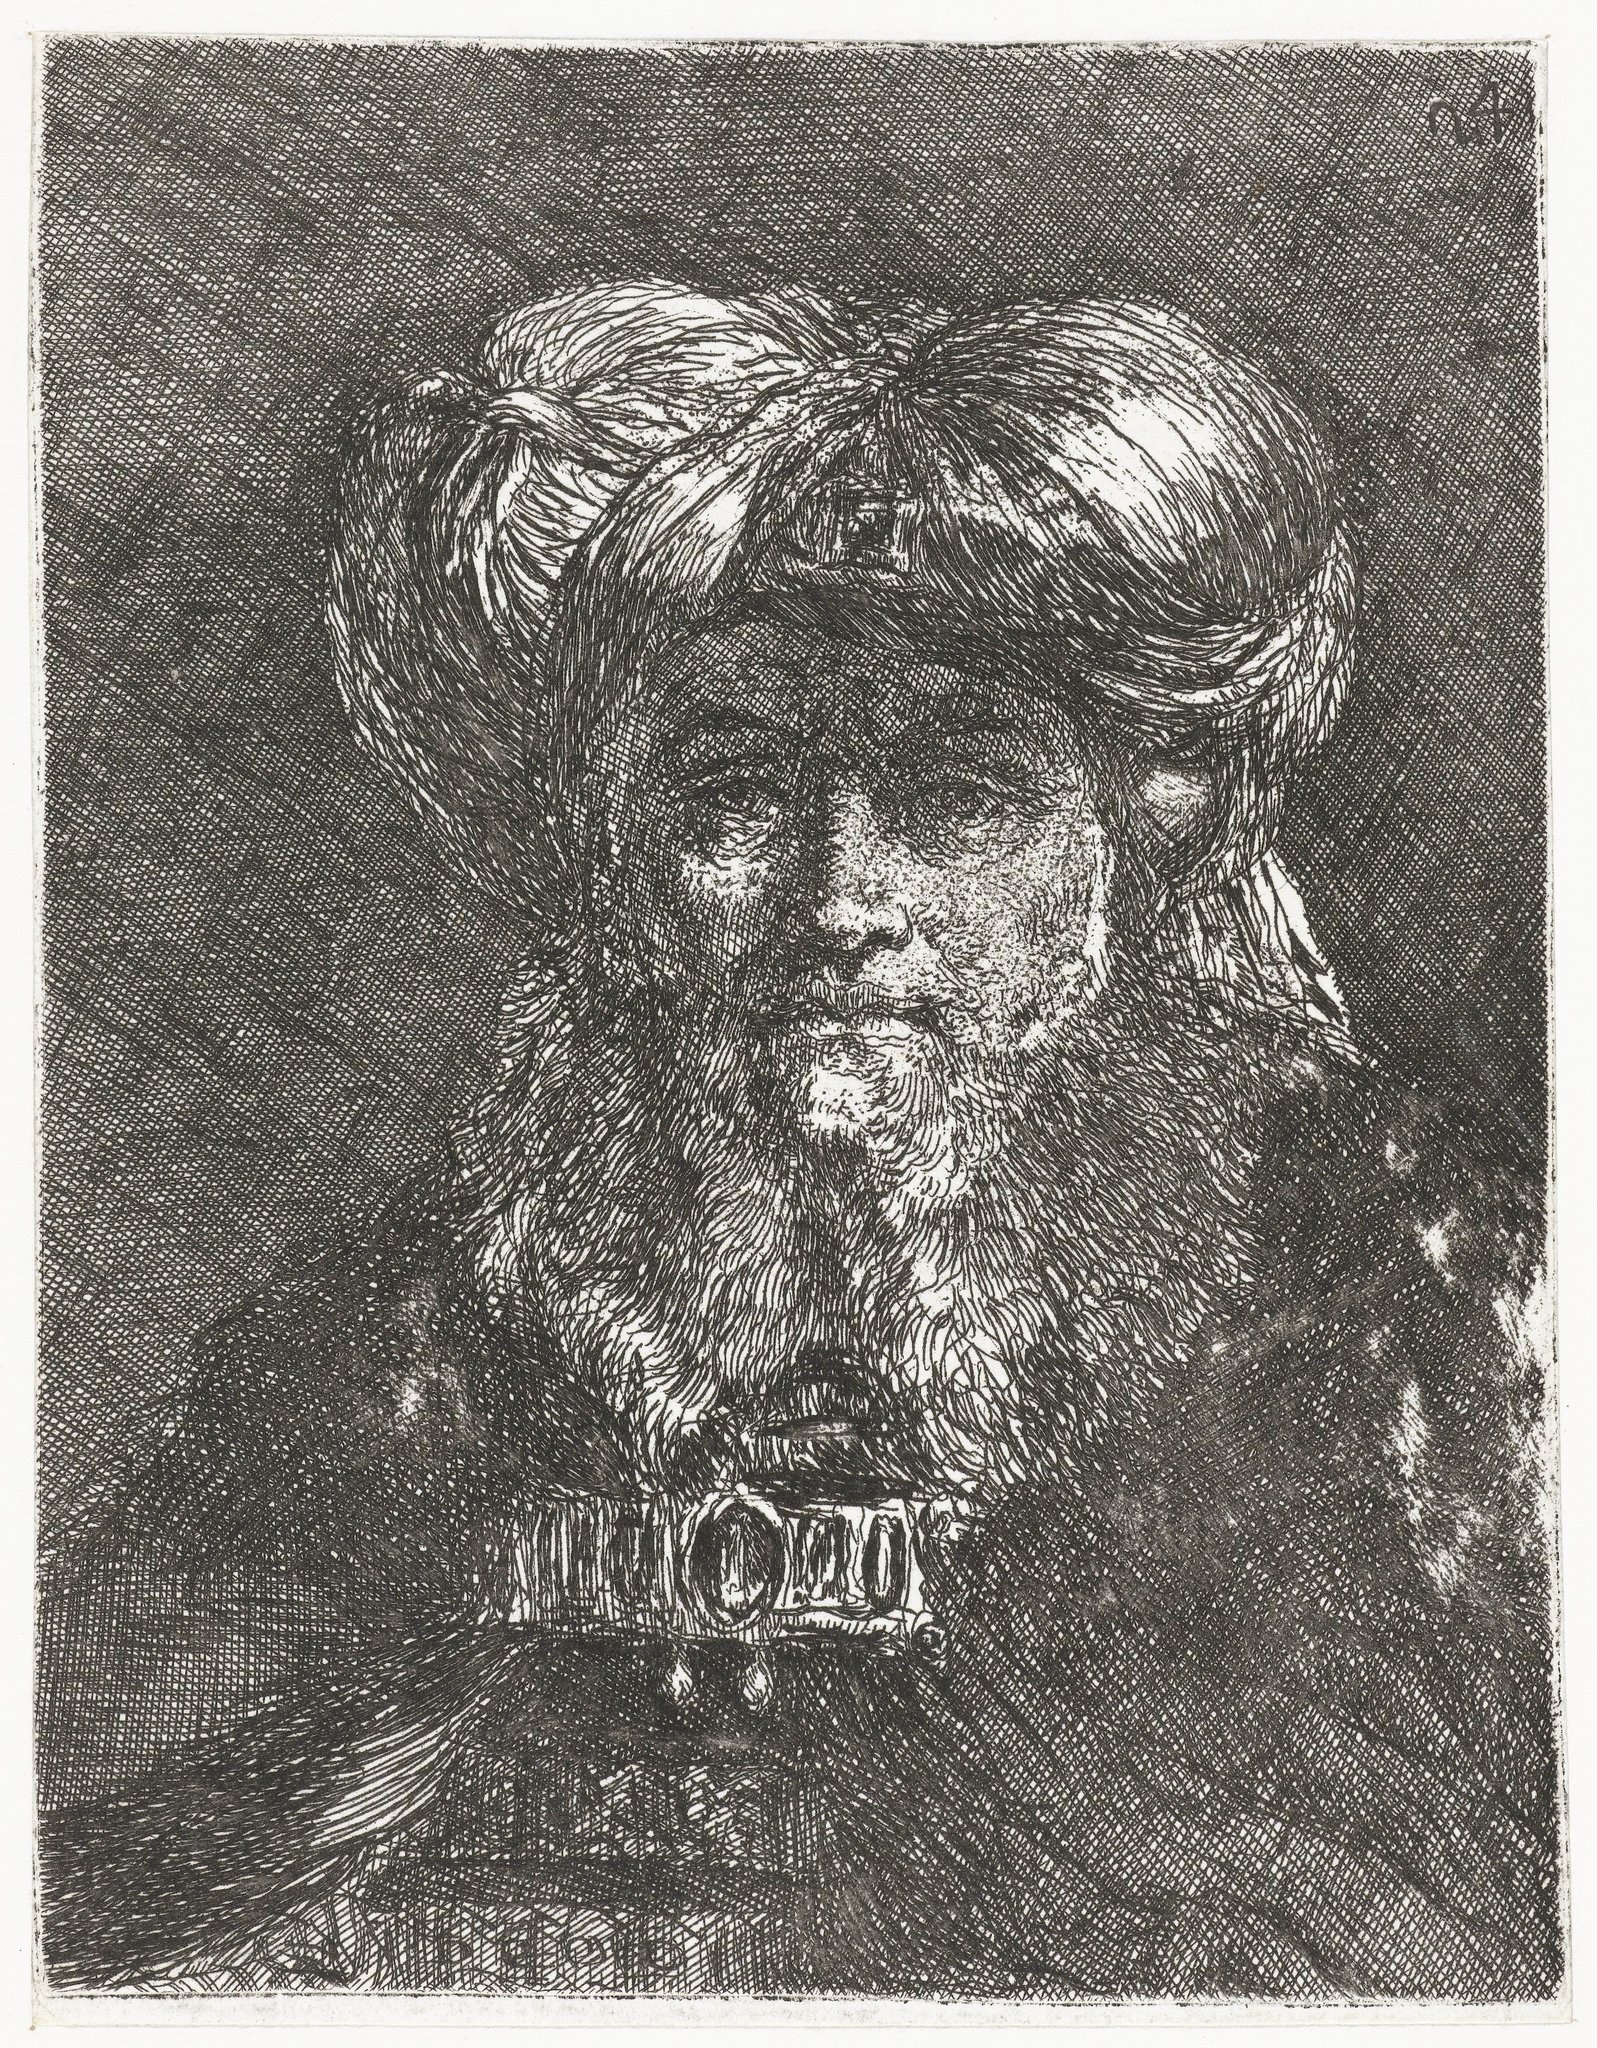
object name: print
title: Verzameling hoofden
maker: giovanni domenico tiepolo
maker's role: draughtsman, print maker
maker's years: 1727-1804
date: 1756-1757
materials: paper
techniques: etching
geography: venice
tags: head-gear: turban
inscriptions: collector's mark: Lugt 2228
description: Prent uit serie Verzameling hoofden (Raccolta di teste). Giovanni Domenico Tiepolo vervaardigde in de winter van 1757-1758 en in de periode van 1771-1774 deze hoofden naar schilderijen en tekeningen van Giovanni Battista Tiepolo. De eerste uitgave verscheen in 1774 in twee delen met elk dertig prenten. Deze prent werd opgenomen in deel 1. Prent mogelijk naar kopie van schilderij van Rembrandt welke in Venetië beschikbaar was aldus Knox 1976, p. 120, nr. 167.